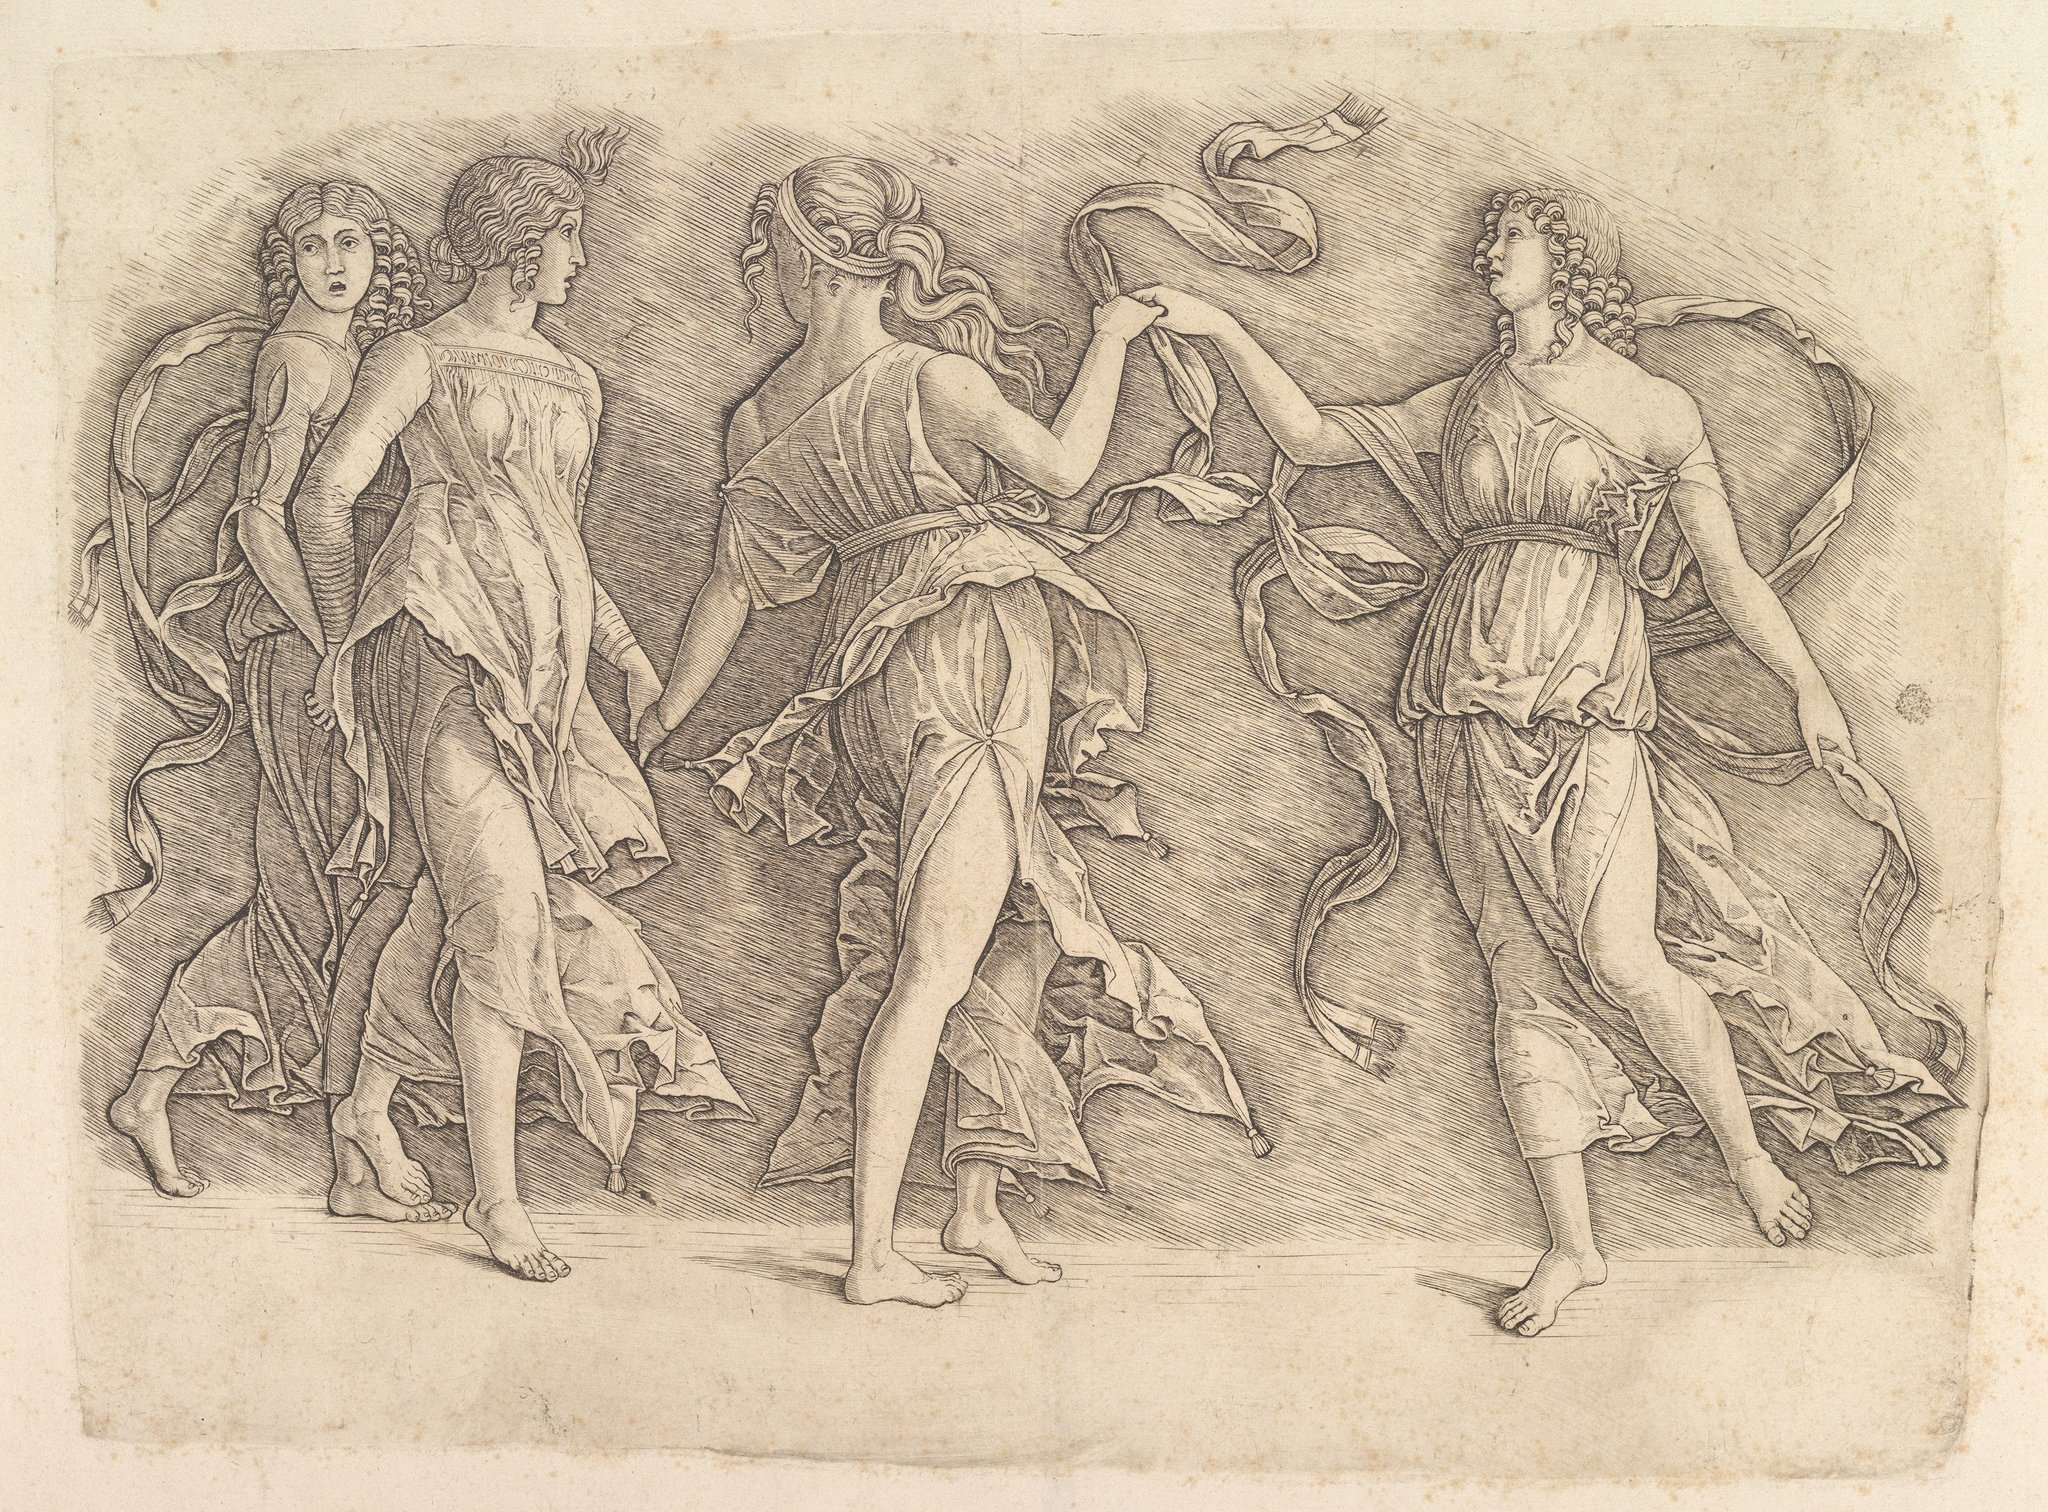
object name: print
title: Four Dancing Muses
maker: gian marco cavalli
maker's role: artist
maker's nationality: italian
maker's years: 1454-1508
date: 1497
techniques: engraving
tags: dancing,muses